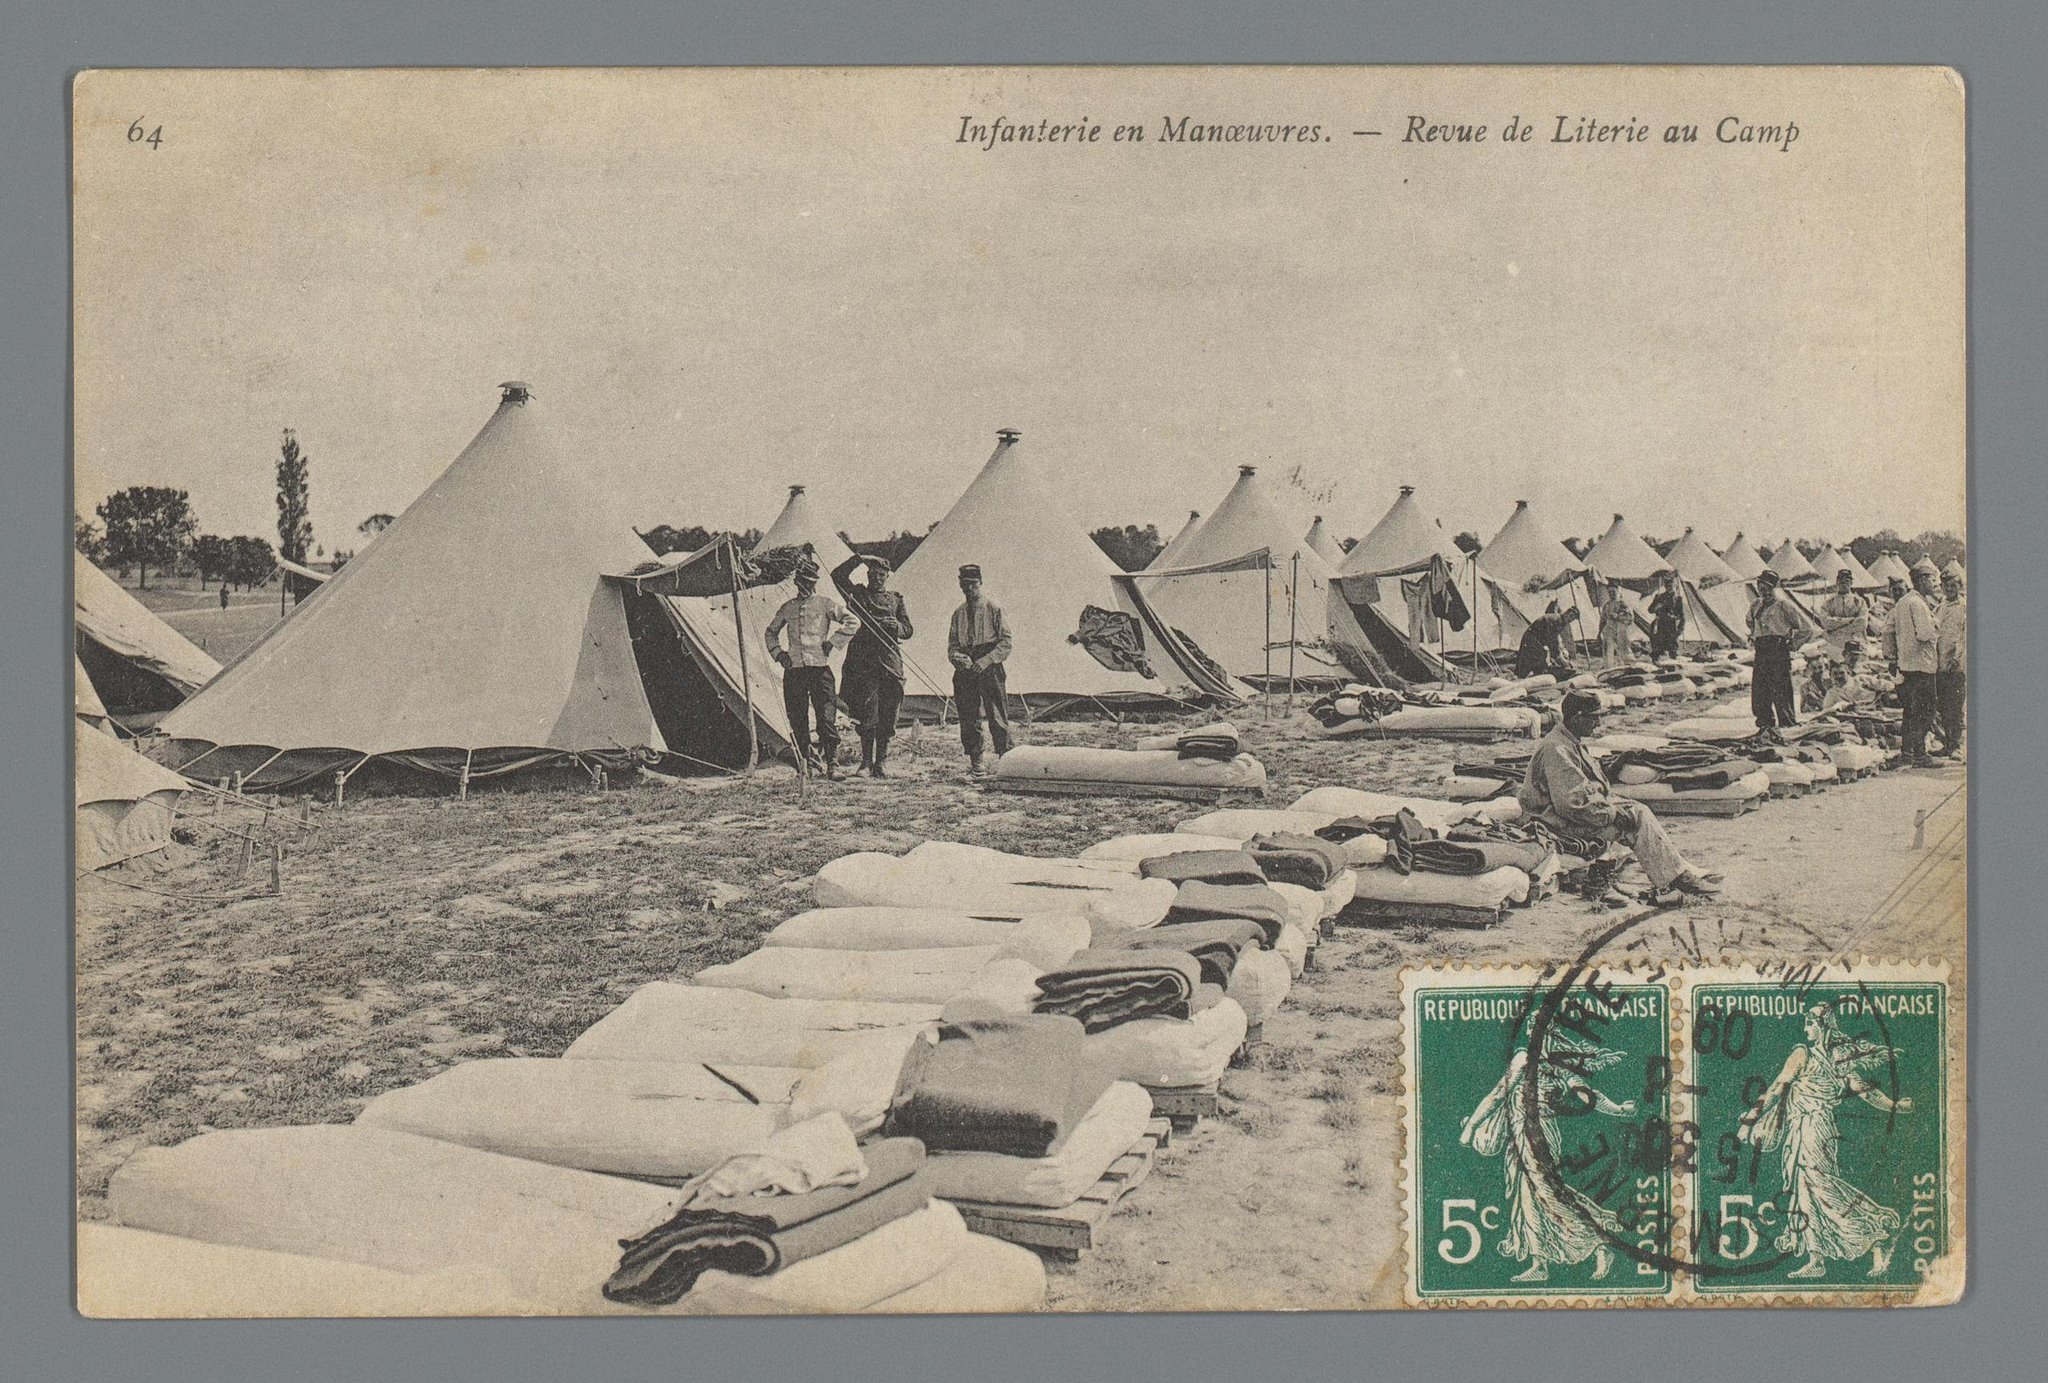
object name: ansichtkaart, prentbriefkaart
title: Revue de literie au camp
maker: Anonymous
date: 1909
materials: paper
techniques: photograph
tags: (military) camp with tents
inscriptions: inscription: ‘Un bonjour/ amical de/ Châlons, en route/ pr. l'alsace/ bien i tous/ L. Ottmary/ Monsieur/ Alfred Huot/ 17 [...]/ Aubervilliers/ [...]’, inscription: ‘Tous les pays étrangers n'acceptent pas la correspondance au recto./ Se renseigner à la poste.’, number: ‘64’